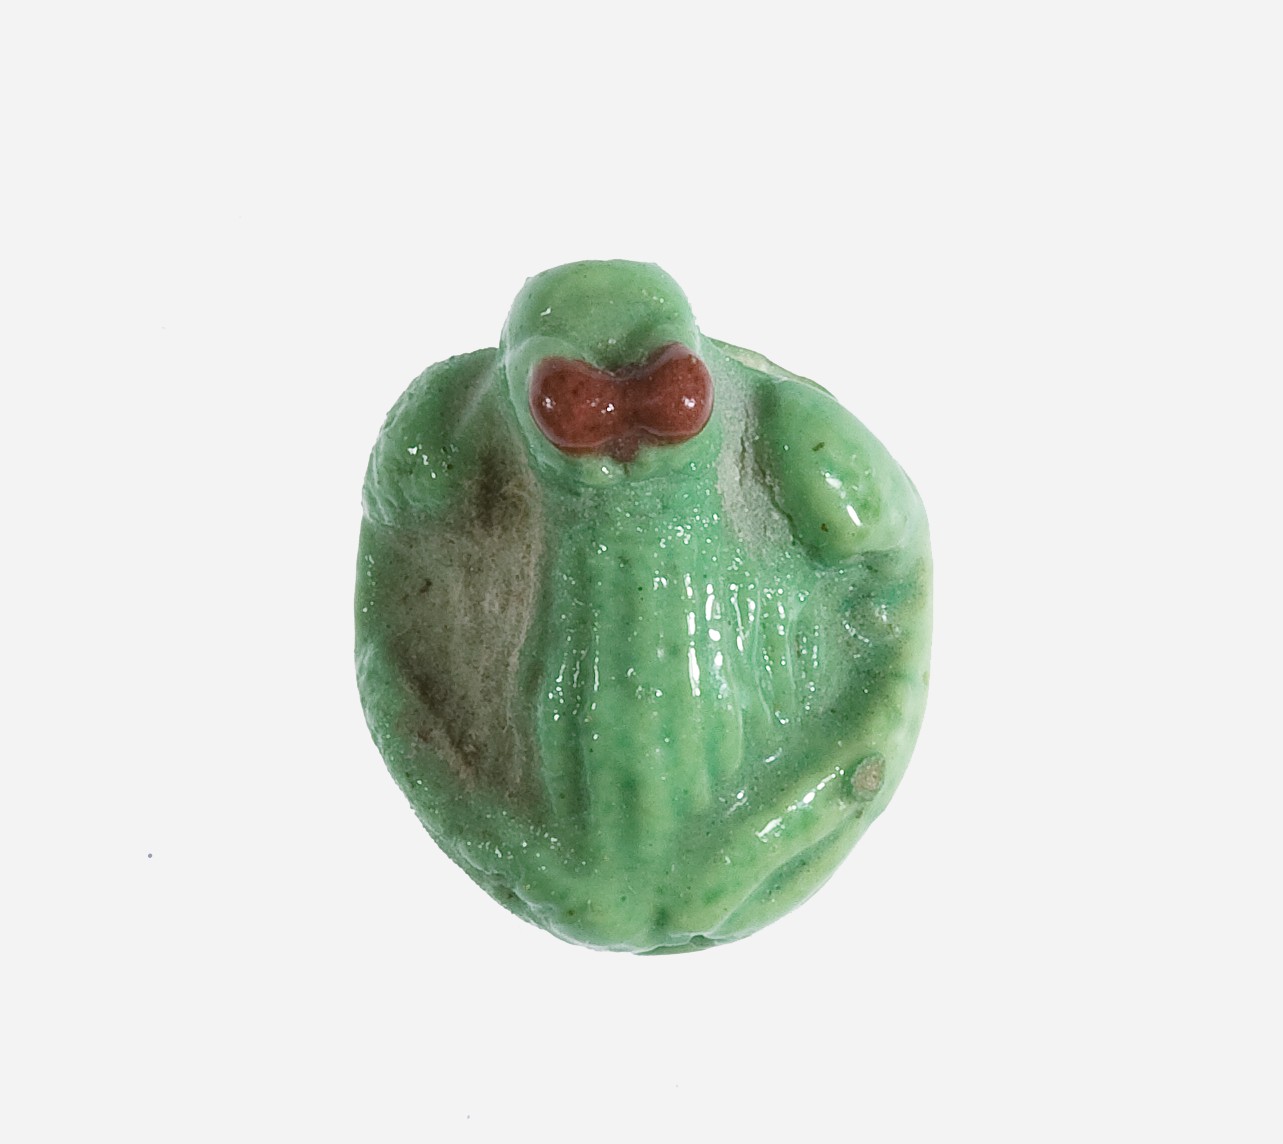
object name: stamp seal, frog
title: Frog Seal Amulet with the Hieroglyphs Nefer and Maat on the Base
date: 1390-1352 BCE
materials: faience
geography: egypt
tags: hieroglyphs,frogs